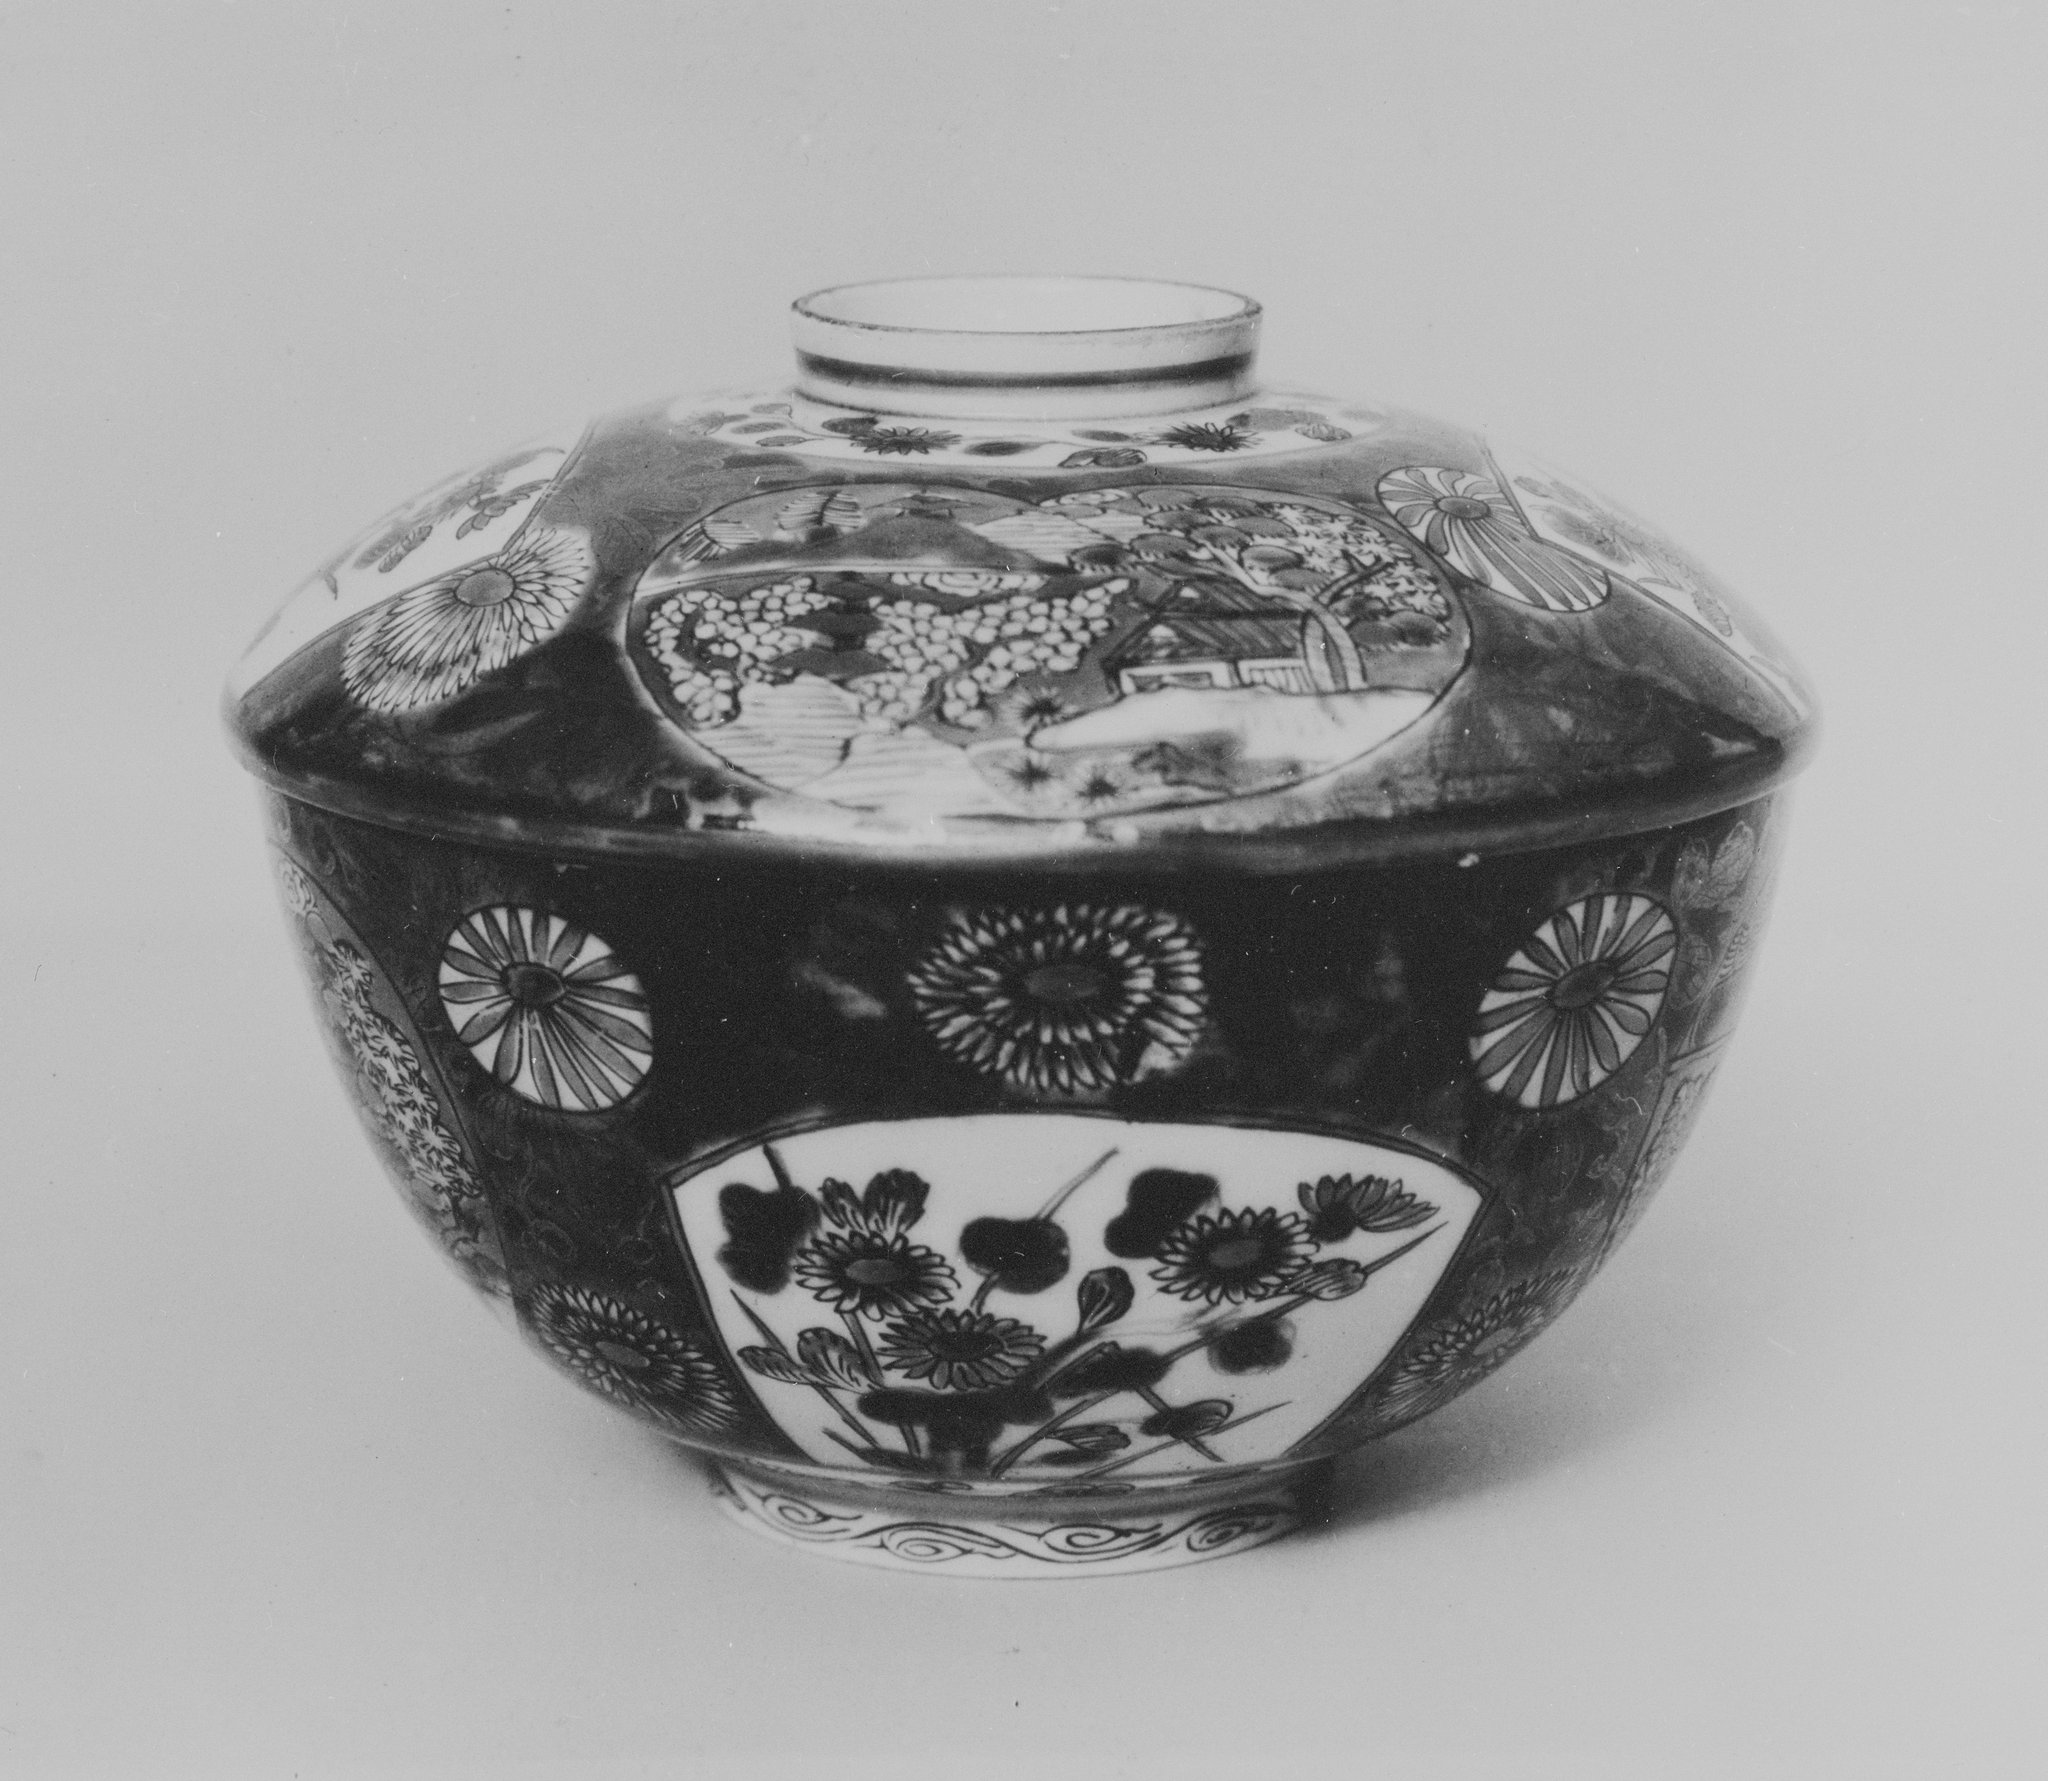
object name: bowl with cover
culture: japanese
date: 1800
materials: enamel, porcelain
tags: flowers